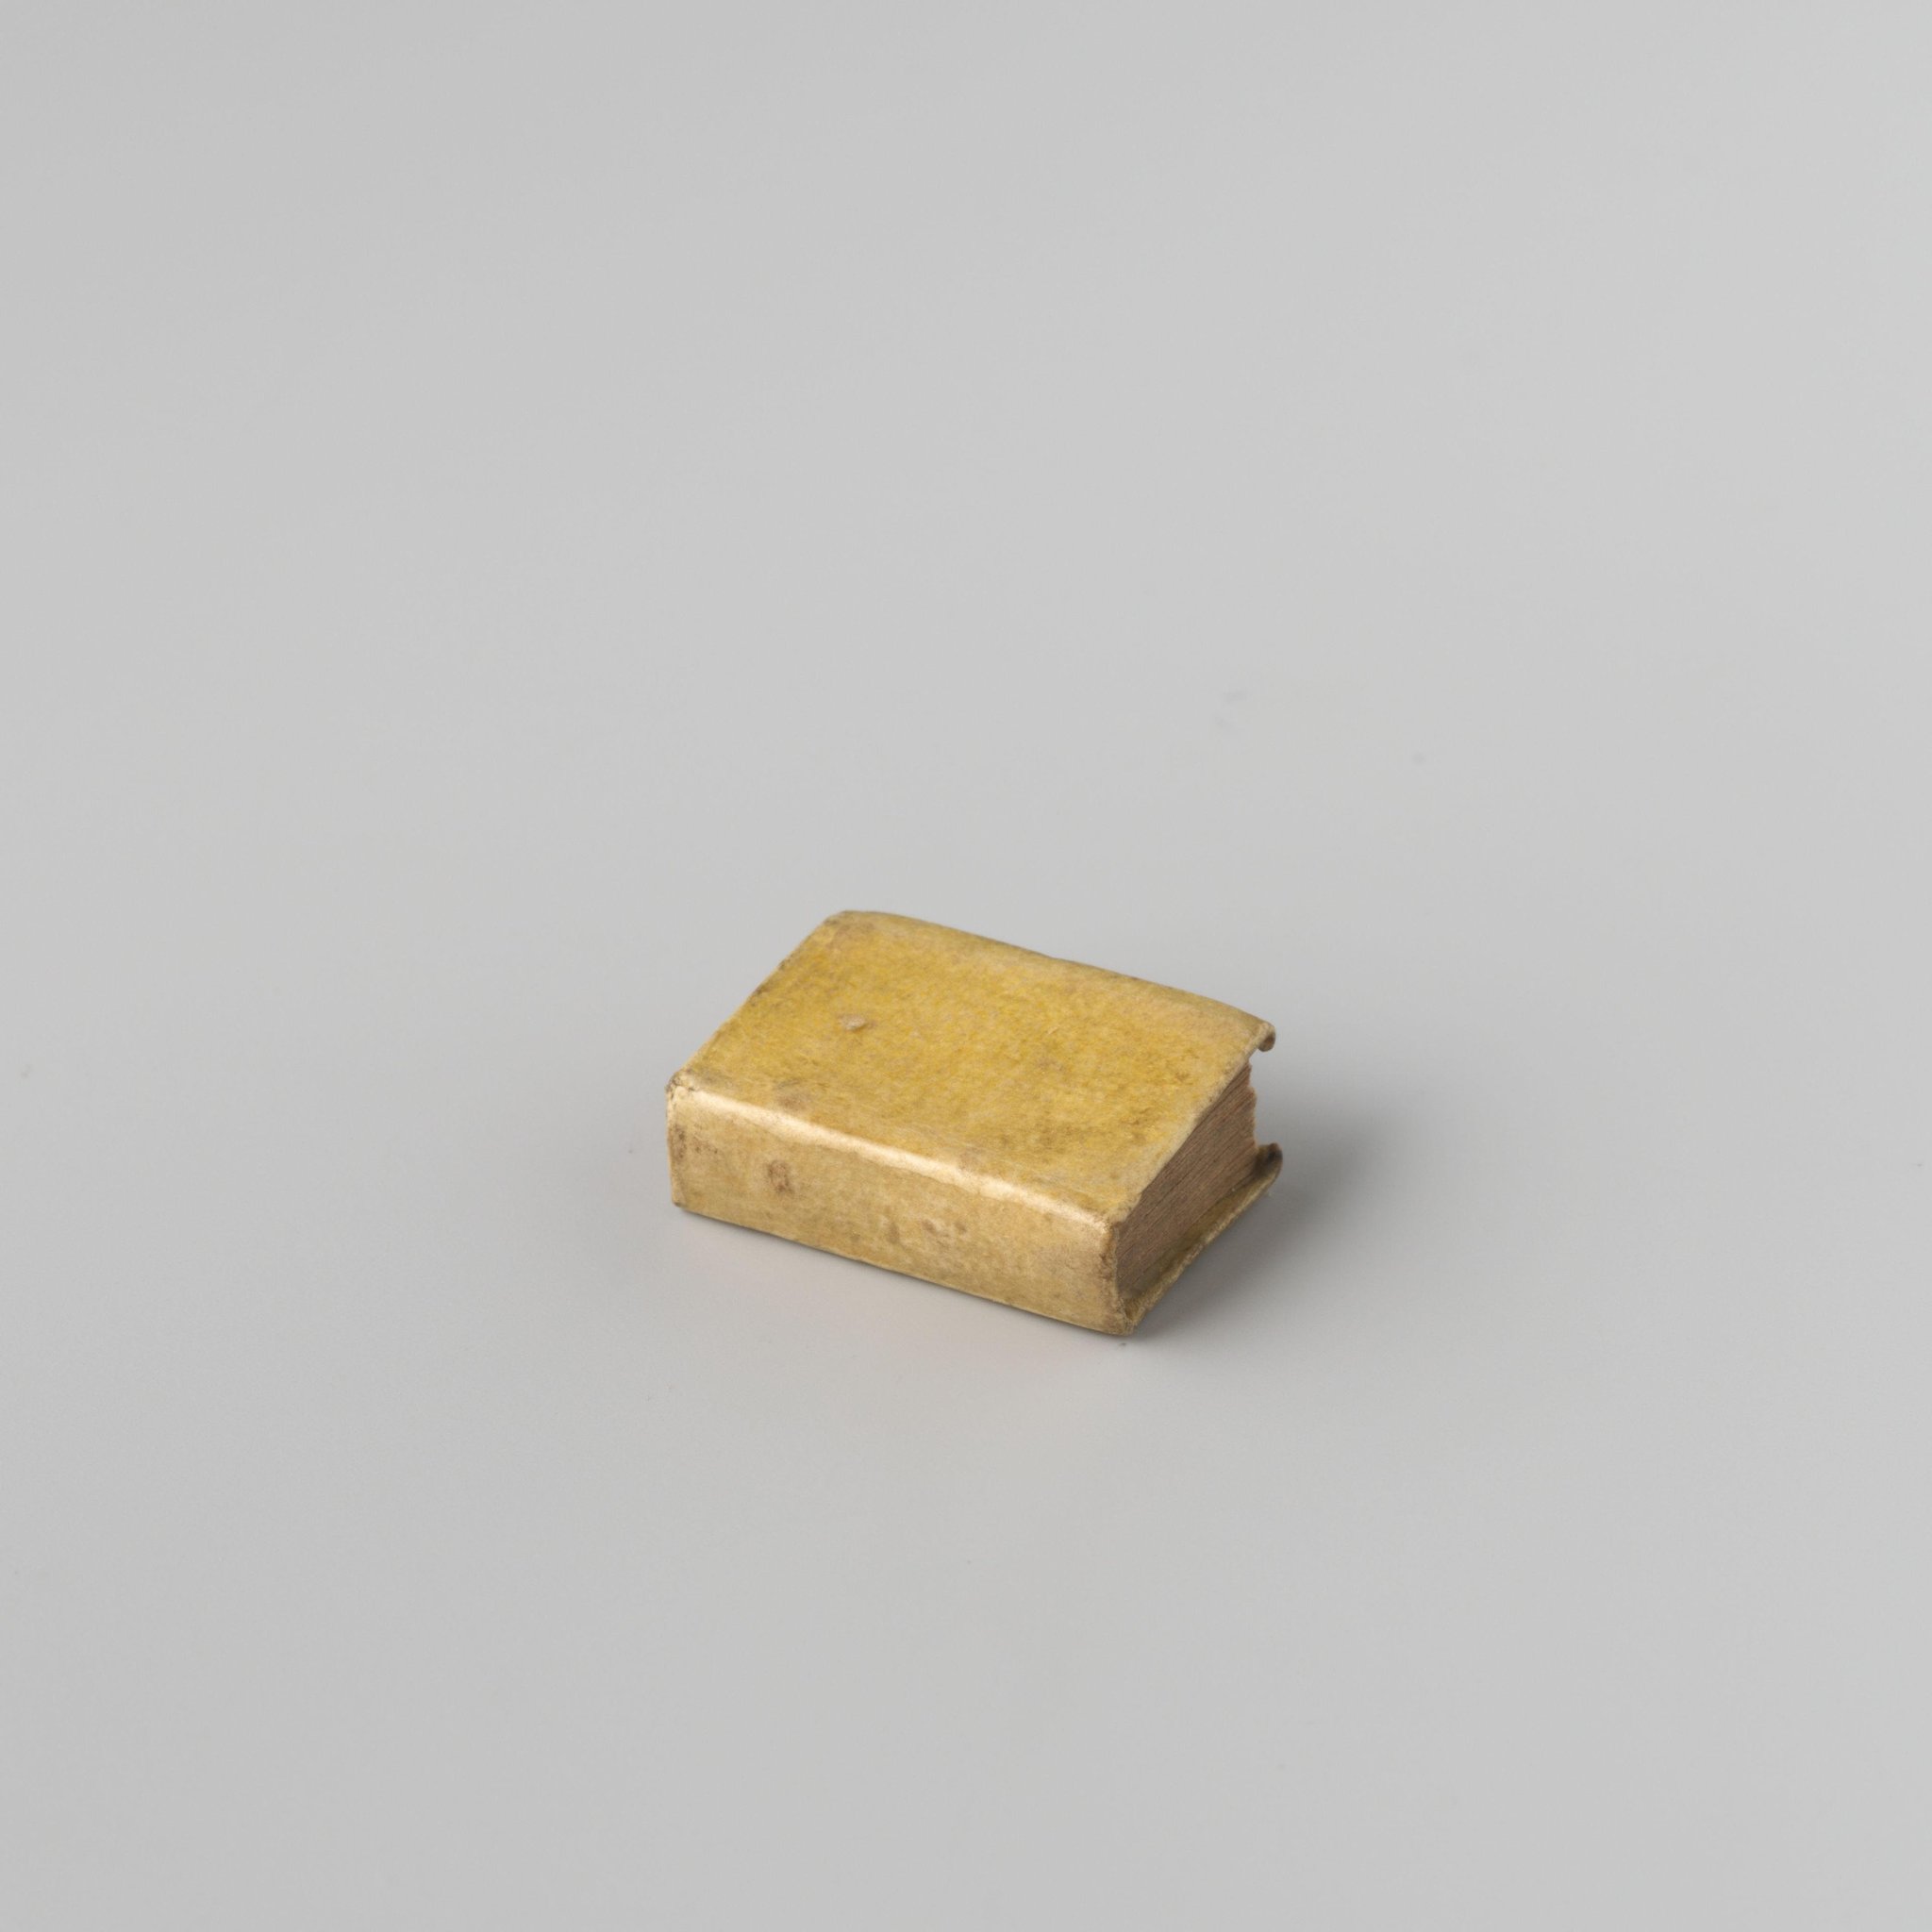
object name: book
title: Boek met letters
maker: Anonymous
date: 1690-1710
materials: paper, parchment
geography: amsterdam